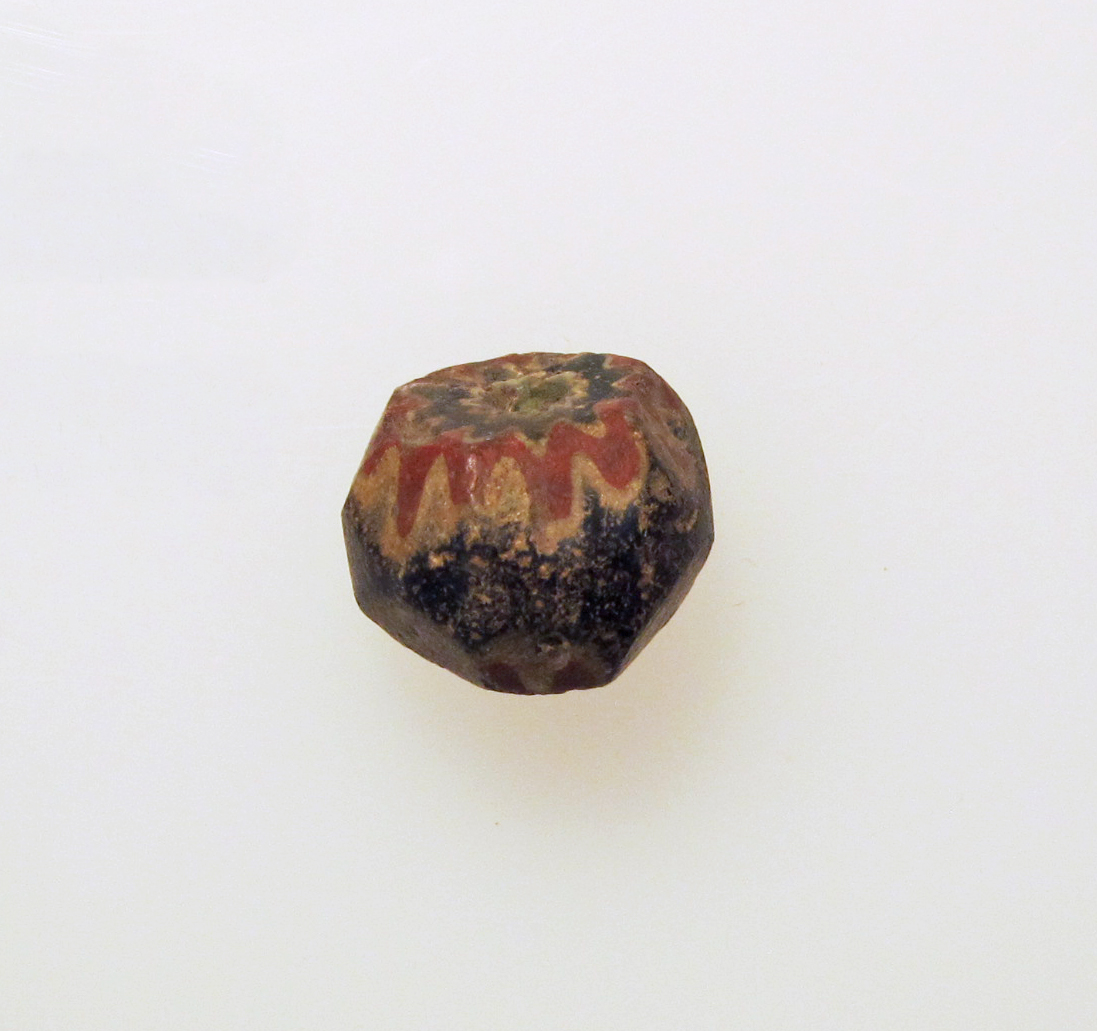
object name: chevron bead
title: Glass chevron bead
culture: venetian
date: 900-100 BCE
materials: glass